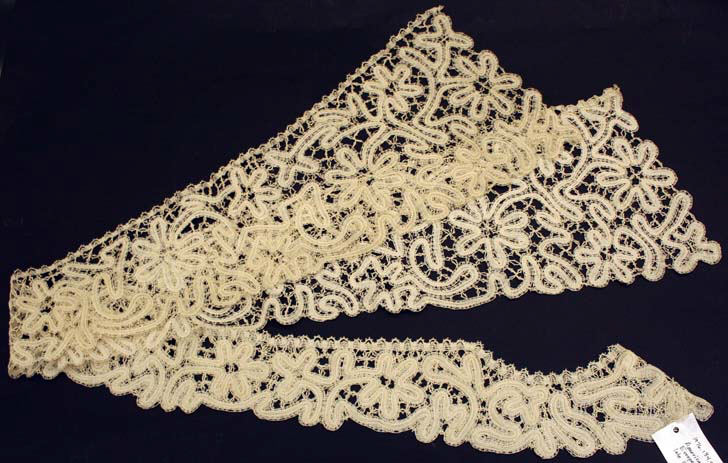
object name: collar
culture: american or european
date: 1867-1900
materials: cotton